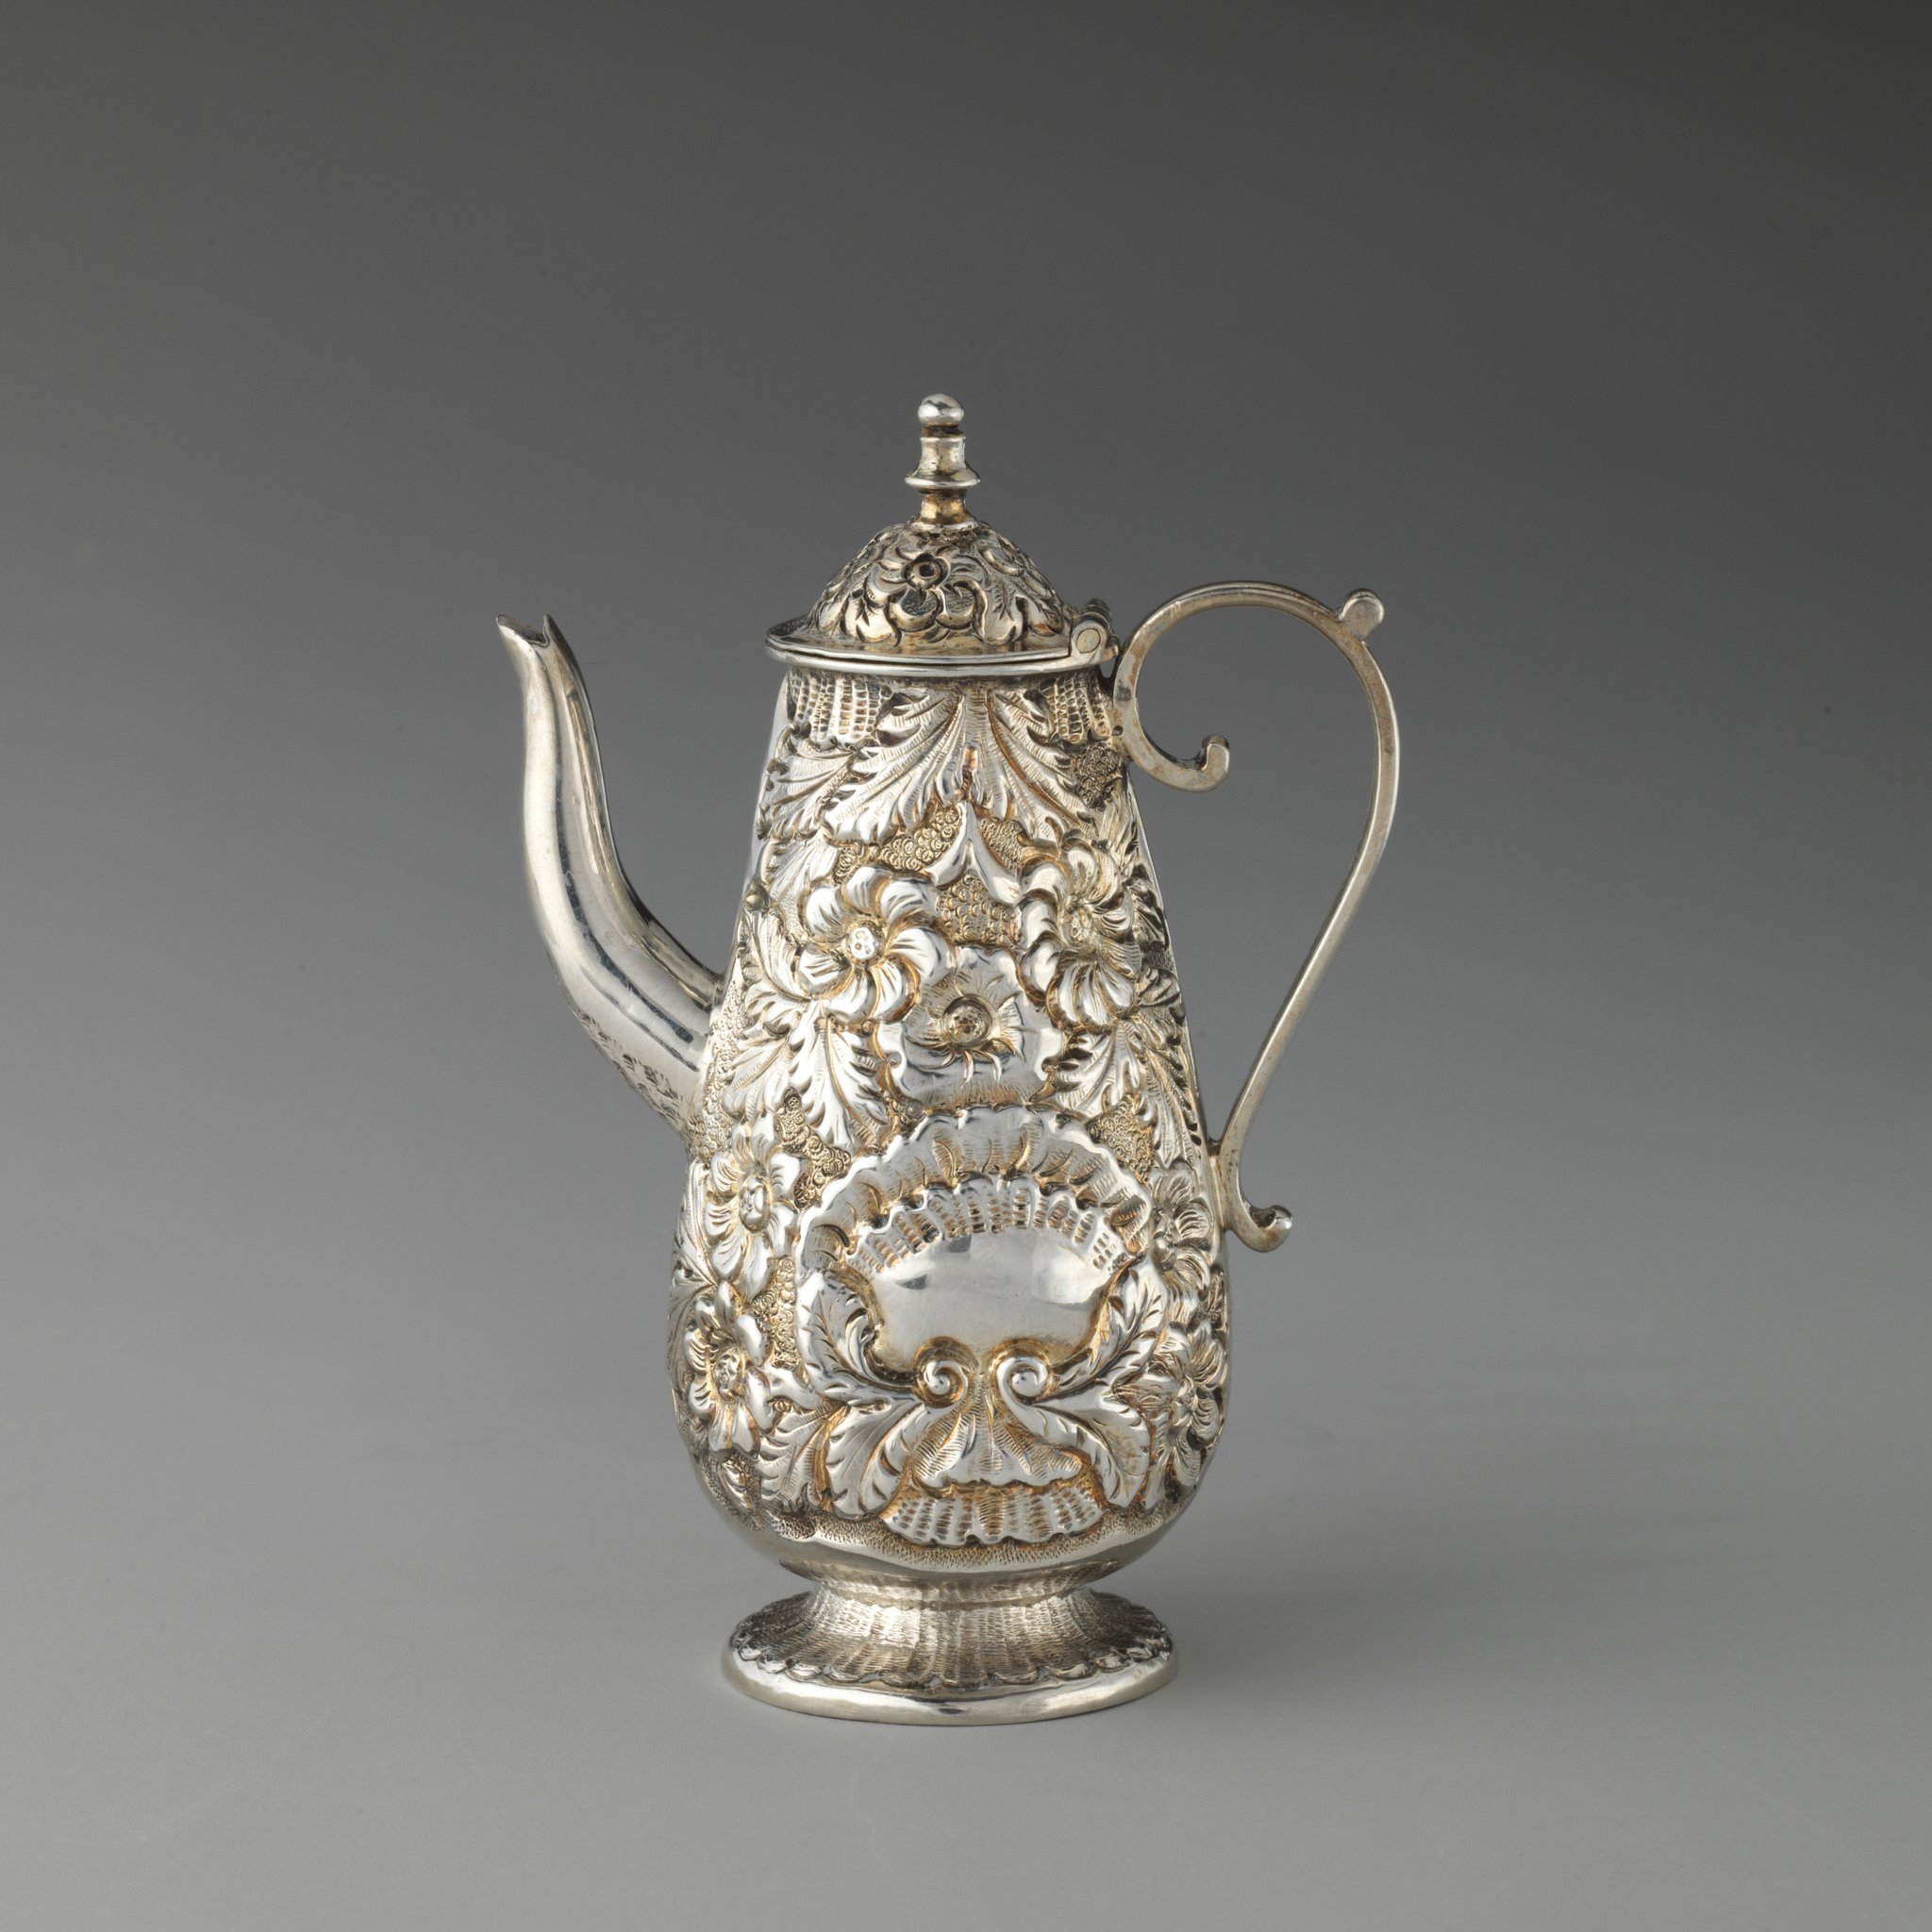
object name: coffeepot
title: Miniature coffeepot (part of a set)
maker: henry flavelle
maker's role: artist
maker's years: 1750-1850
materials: silver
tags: flowers